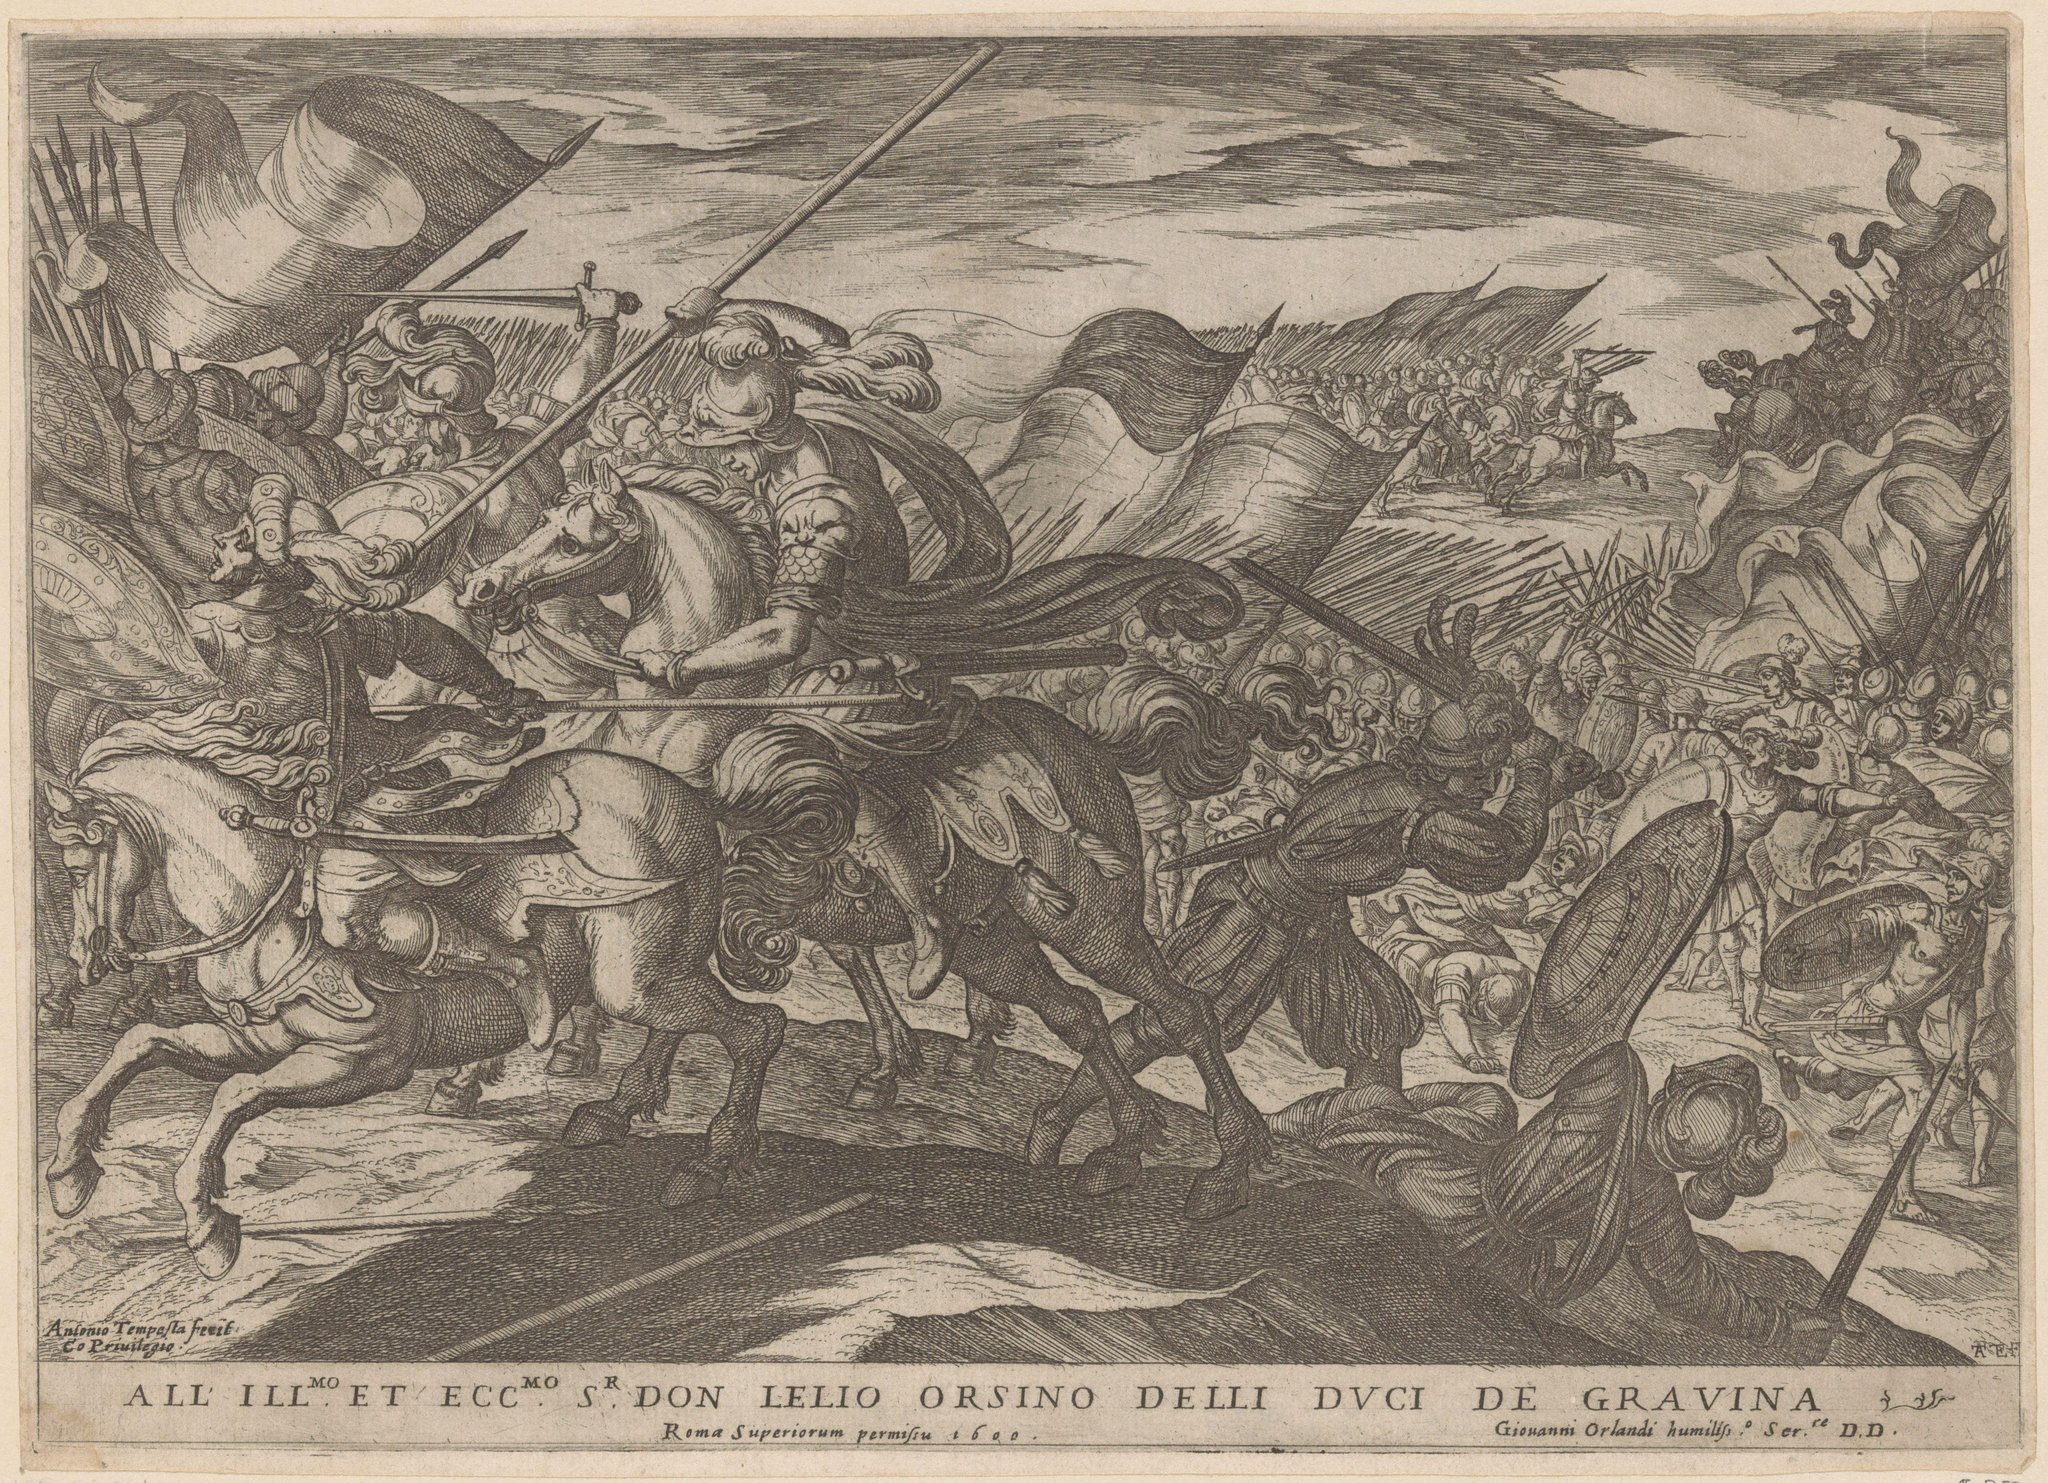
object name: print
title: Gevechtsscènes (serie 3)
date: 1600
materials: paper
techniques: etching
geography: rome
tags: battle, warfare; military affairs (+ cavalry, horsemen), the soldier; the soldier's life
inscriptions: collector's mark: Lugt 240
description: Strijdende soldaten met speren te paard. Opdracht in het Latijn in de ondermarge.